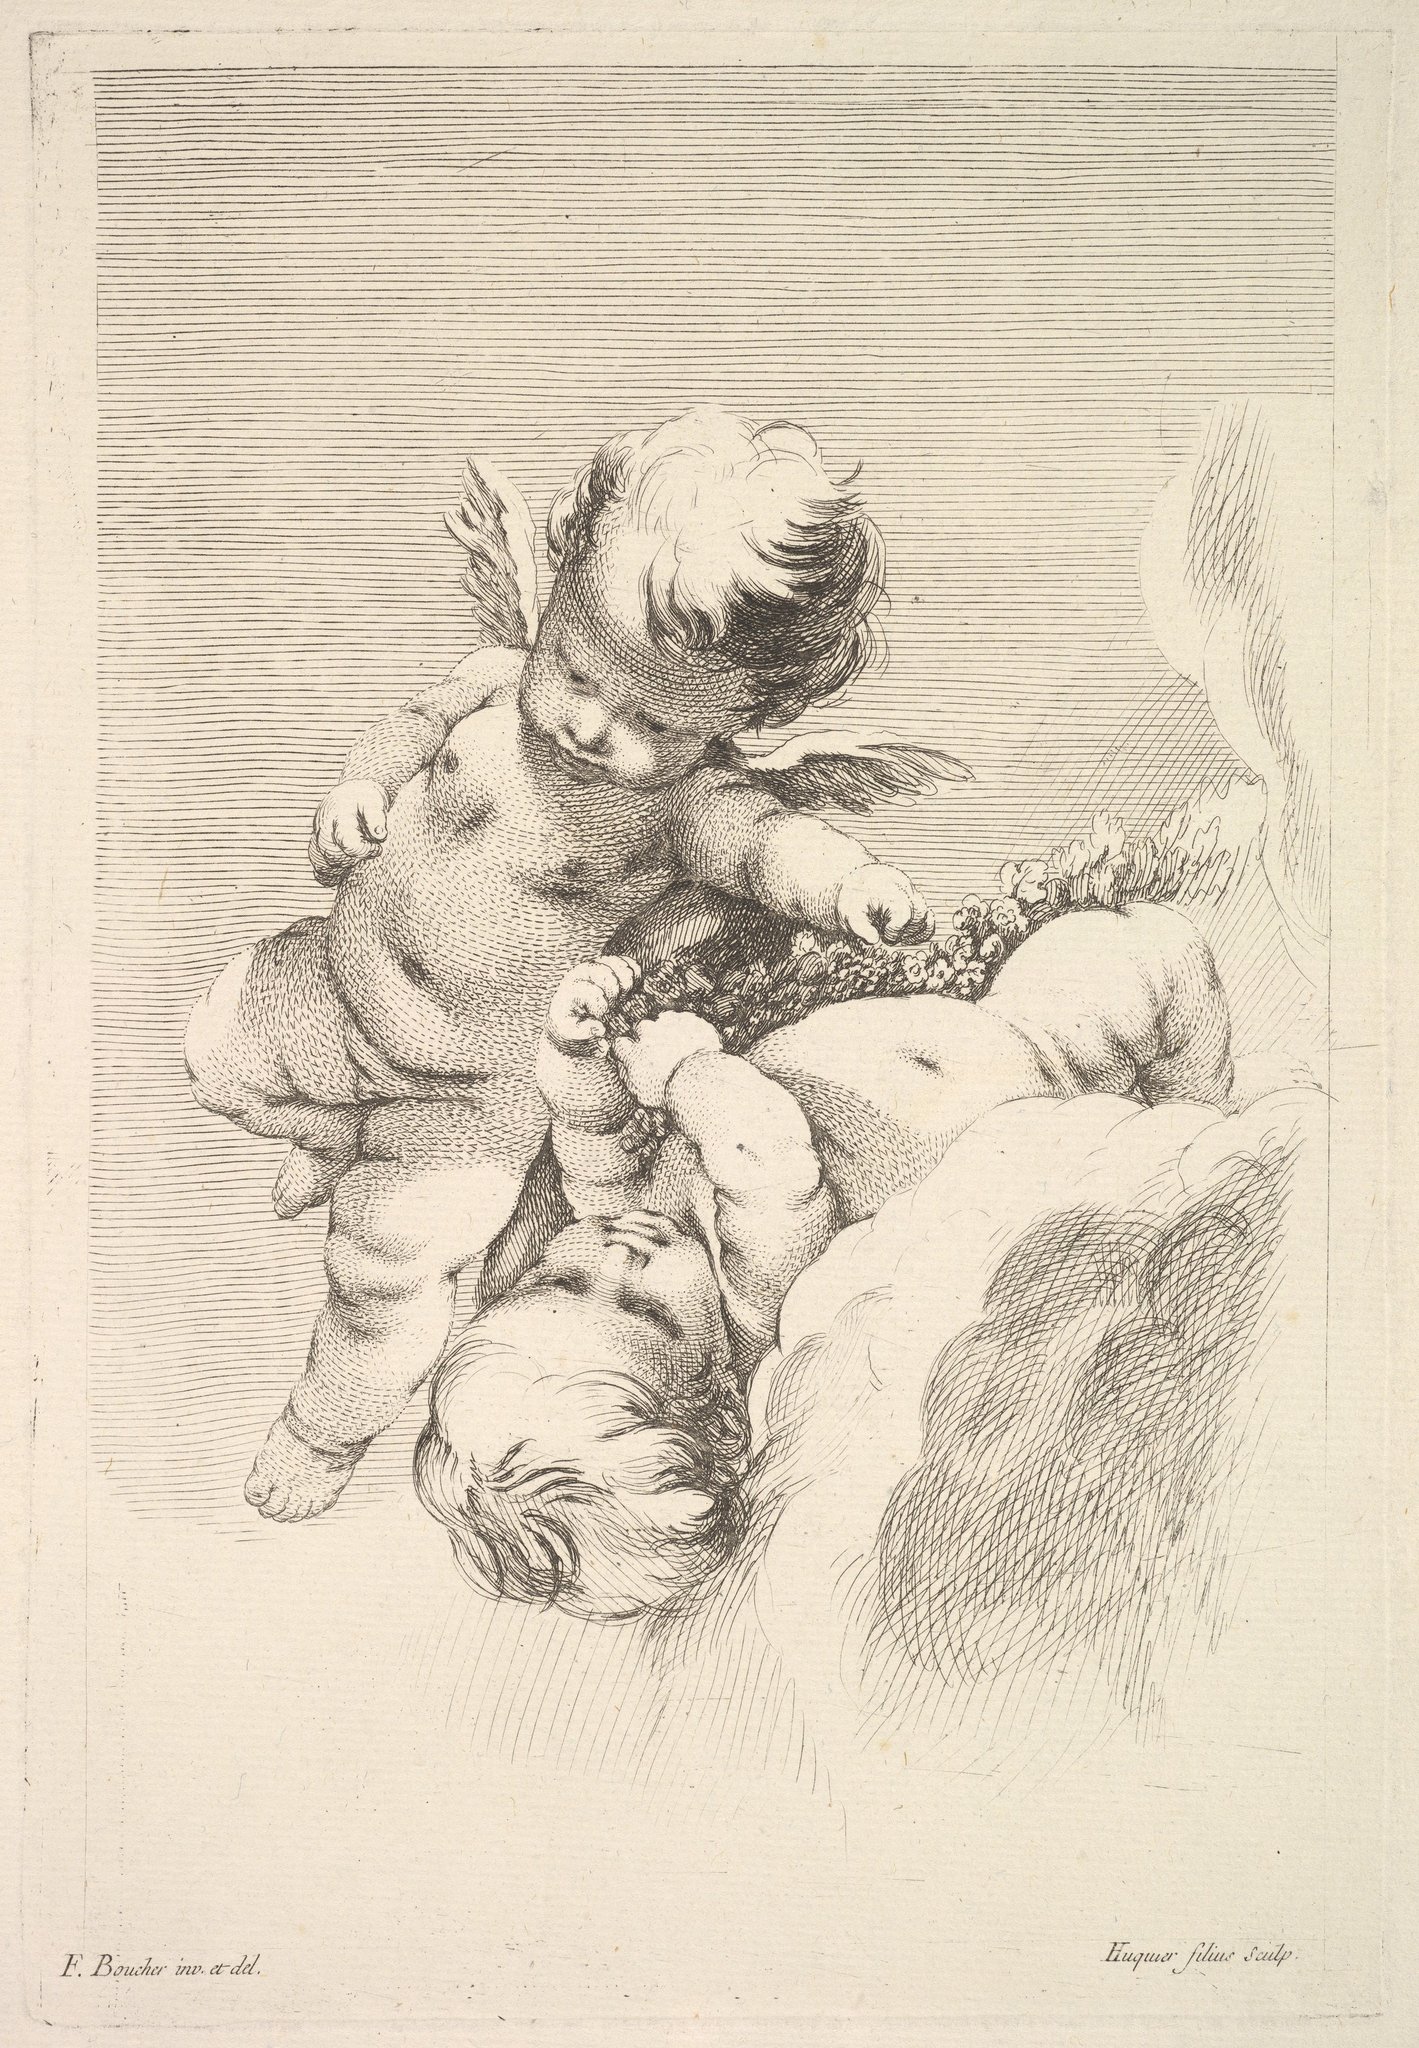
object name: print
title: Two Cupids, One Holding a Wreath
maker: jacques gabriel huquier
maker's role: artist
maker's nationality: french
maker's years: 1730-1805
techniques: engraving, etching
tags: cupid,wreaths